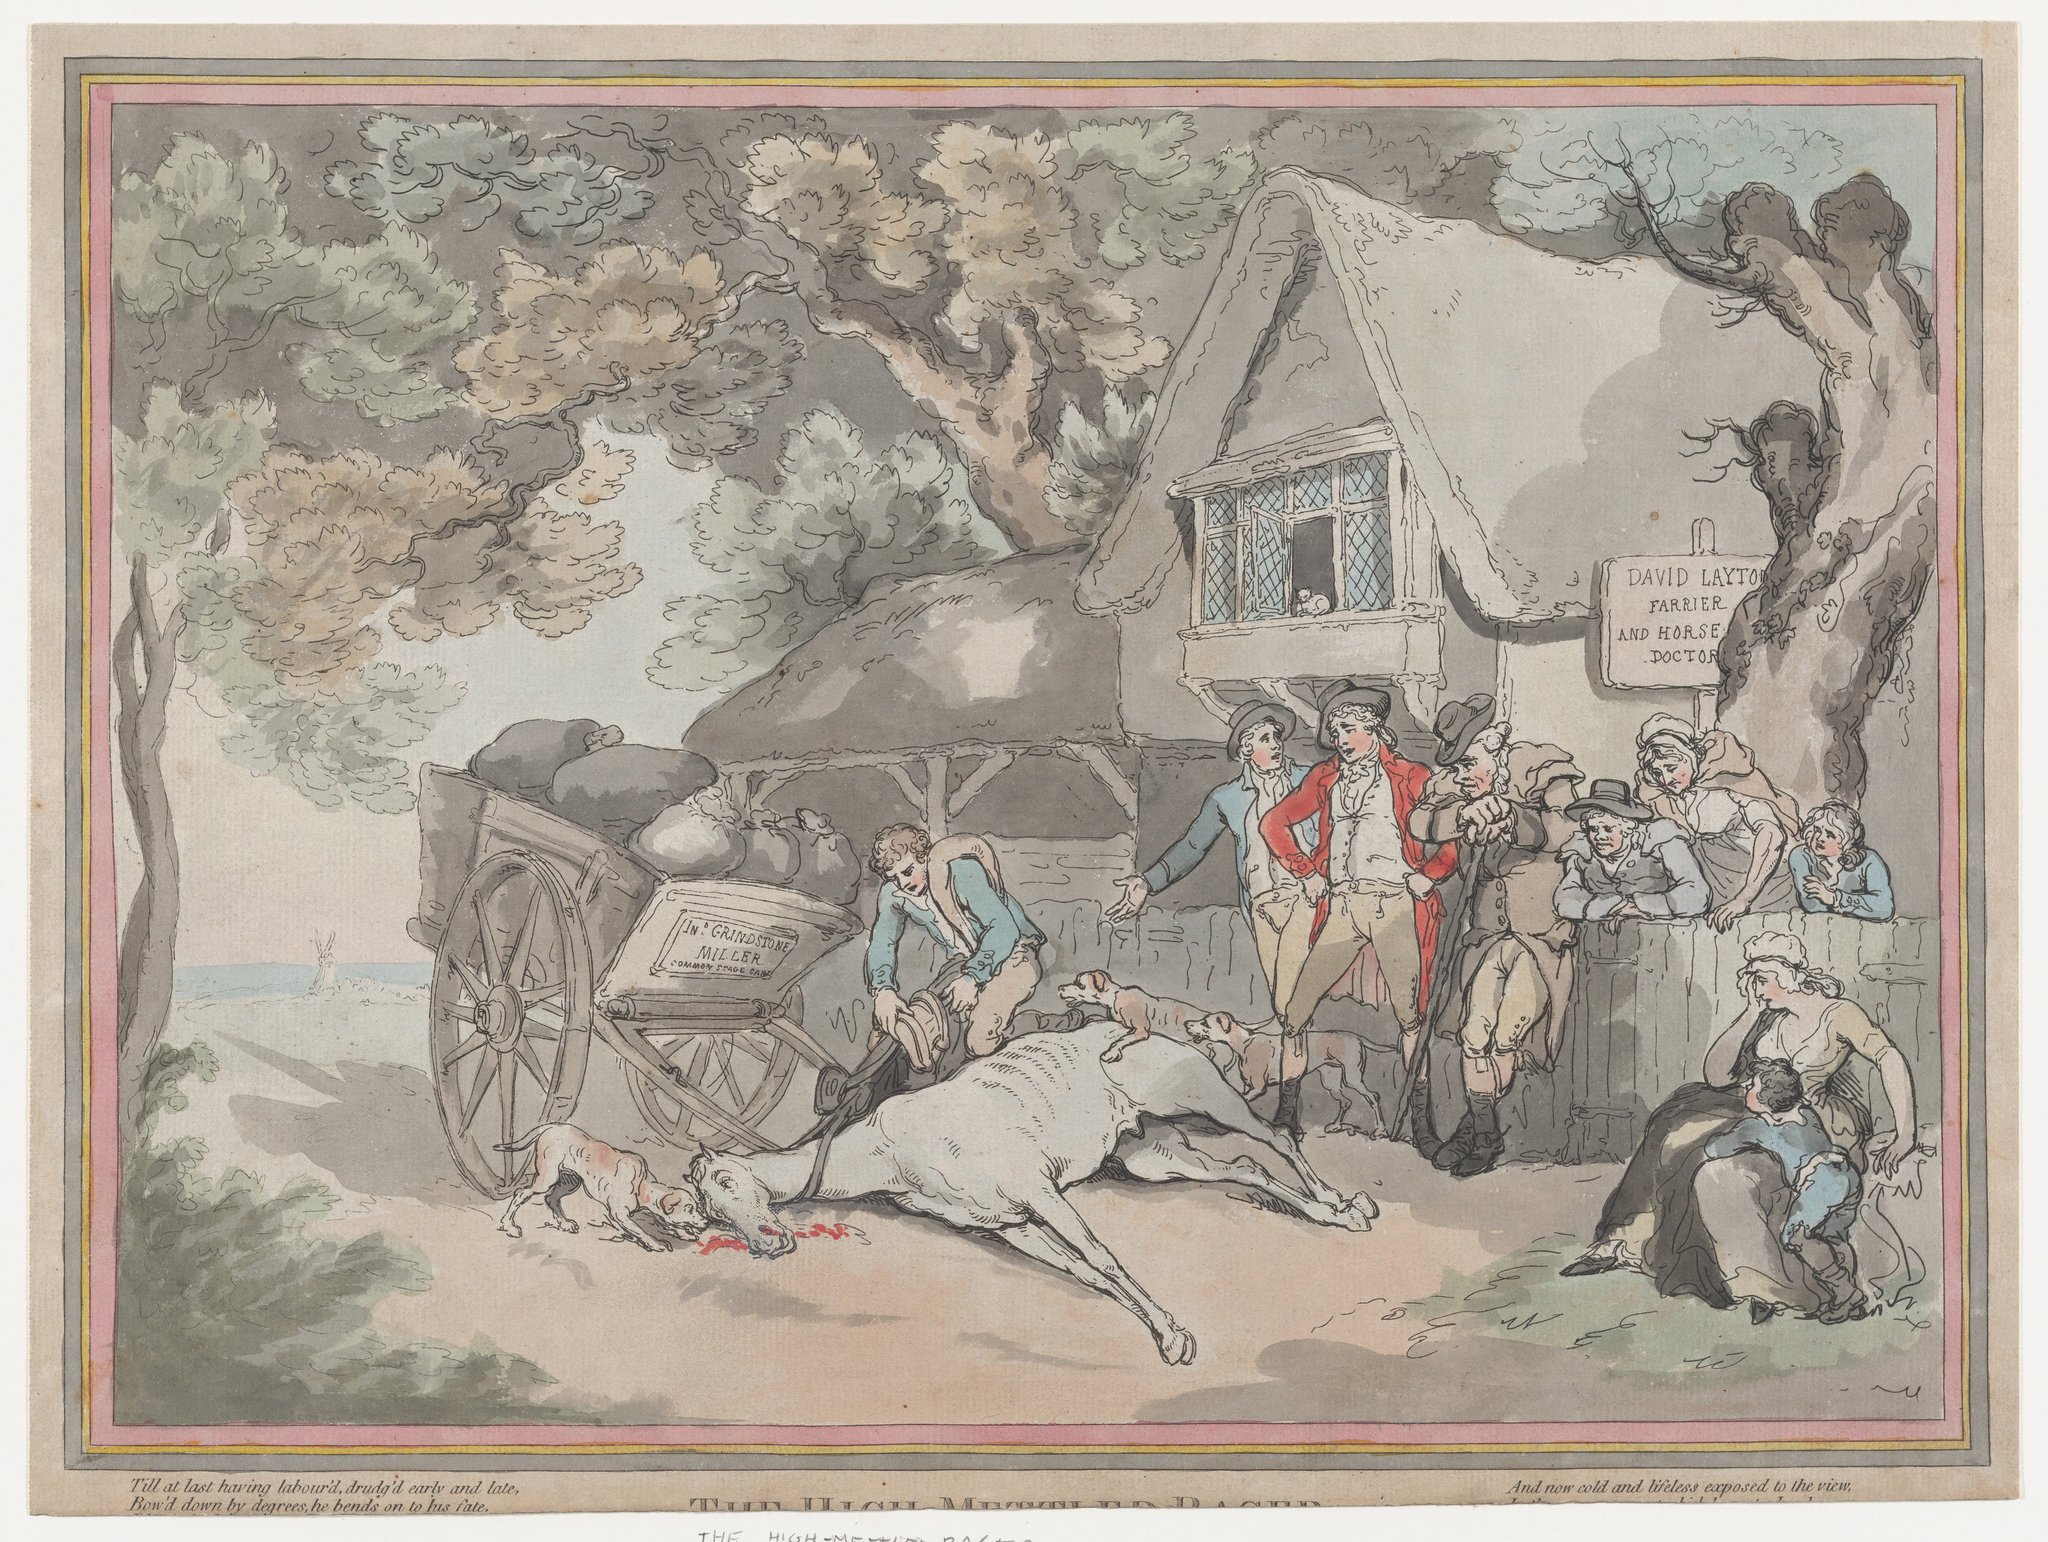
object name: print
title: The Cart Horse (from The Life of a Racehourse, or The High-Mettled Racer)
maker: thomas rowlandson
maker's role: artist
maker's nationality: british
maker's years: 1757-1827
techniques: aquatint, etching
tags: sadness,men,women,dogs,horses